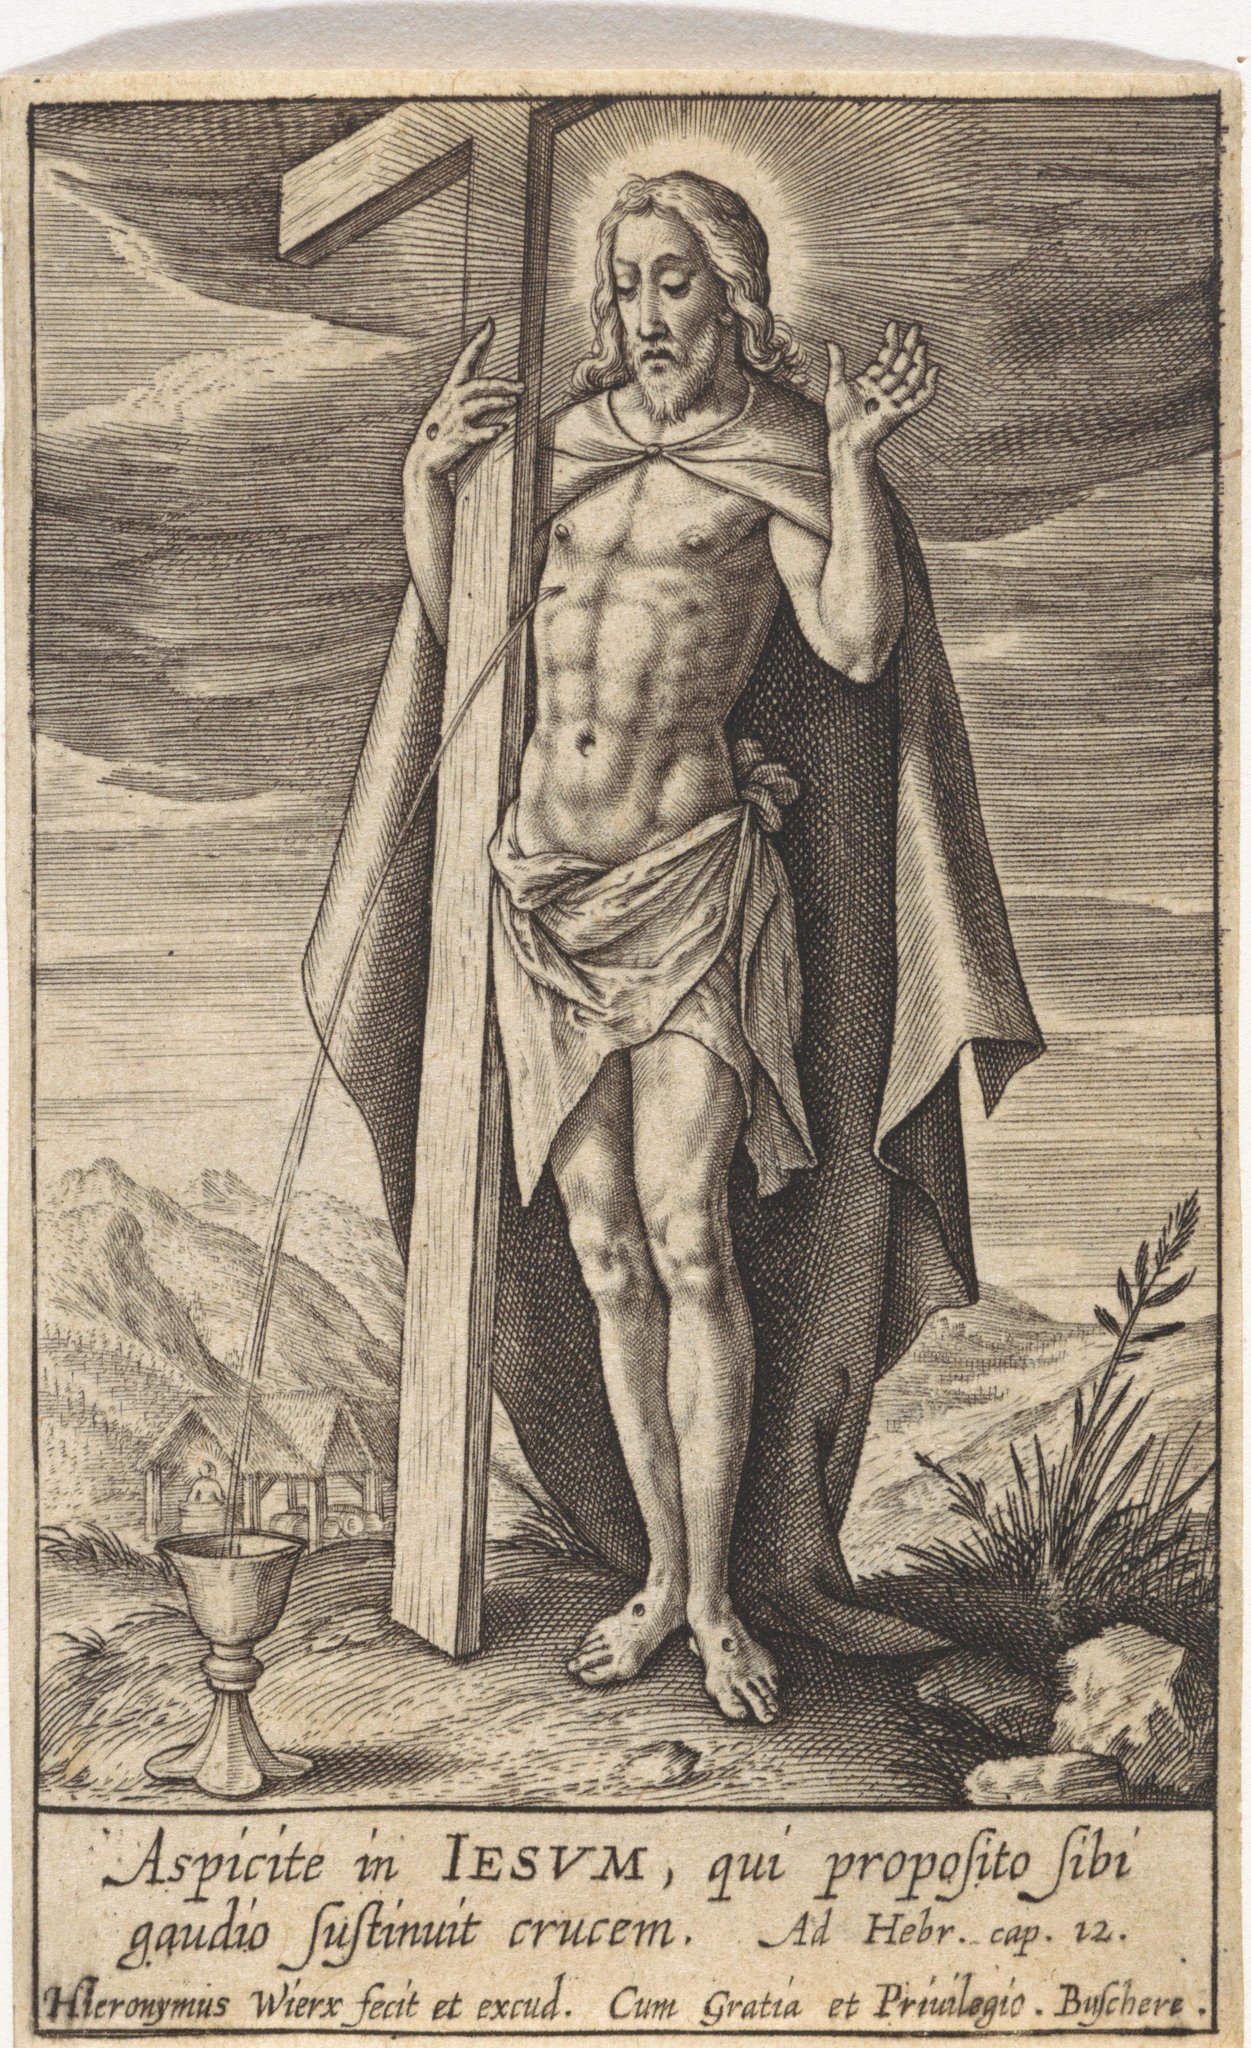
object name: print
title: Bloed van Christus stroomt in miskelk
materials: paper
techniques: engraving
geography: antwerp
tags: blood spouting from christ's wounds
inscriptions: collector's mark: Lugt 2228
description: Christus staat naast het kruis. Het bloed stroomt uit de wond in zijn zijde in een miskelk. Links op de achtergrond een wijnpers. In de marge een tweeregelig Bijbelcitaat uit Heb. 12 in het Latijn.